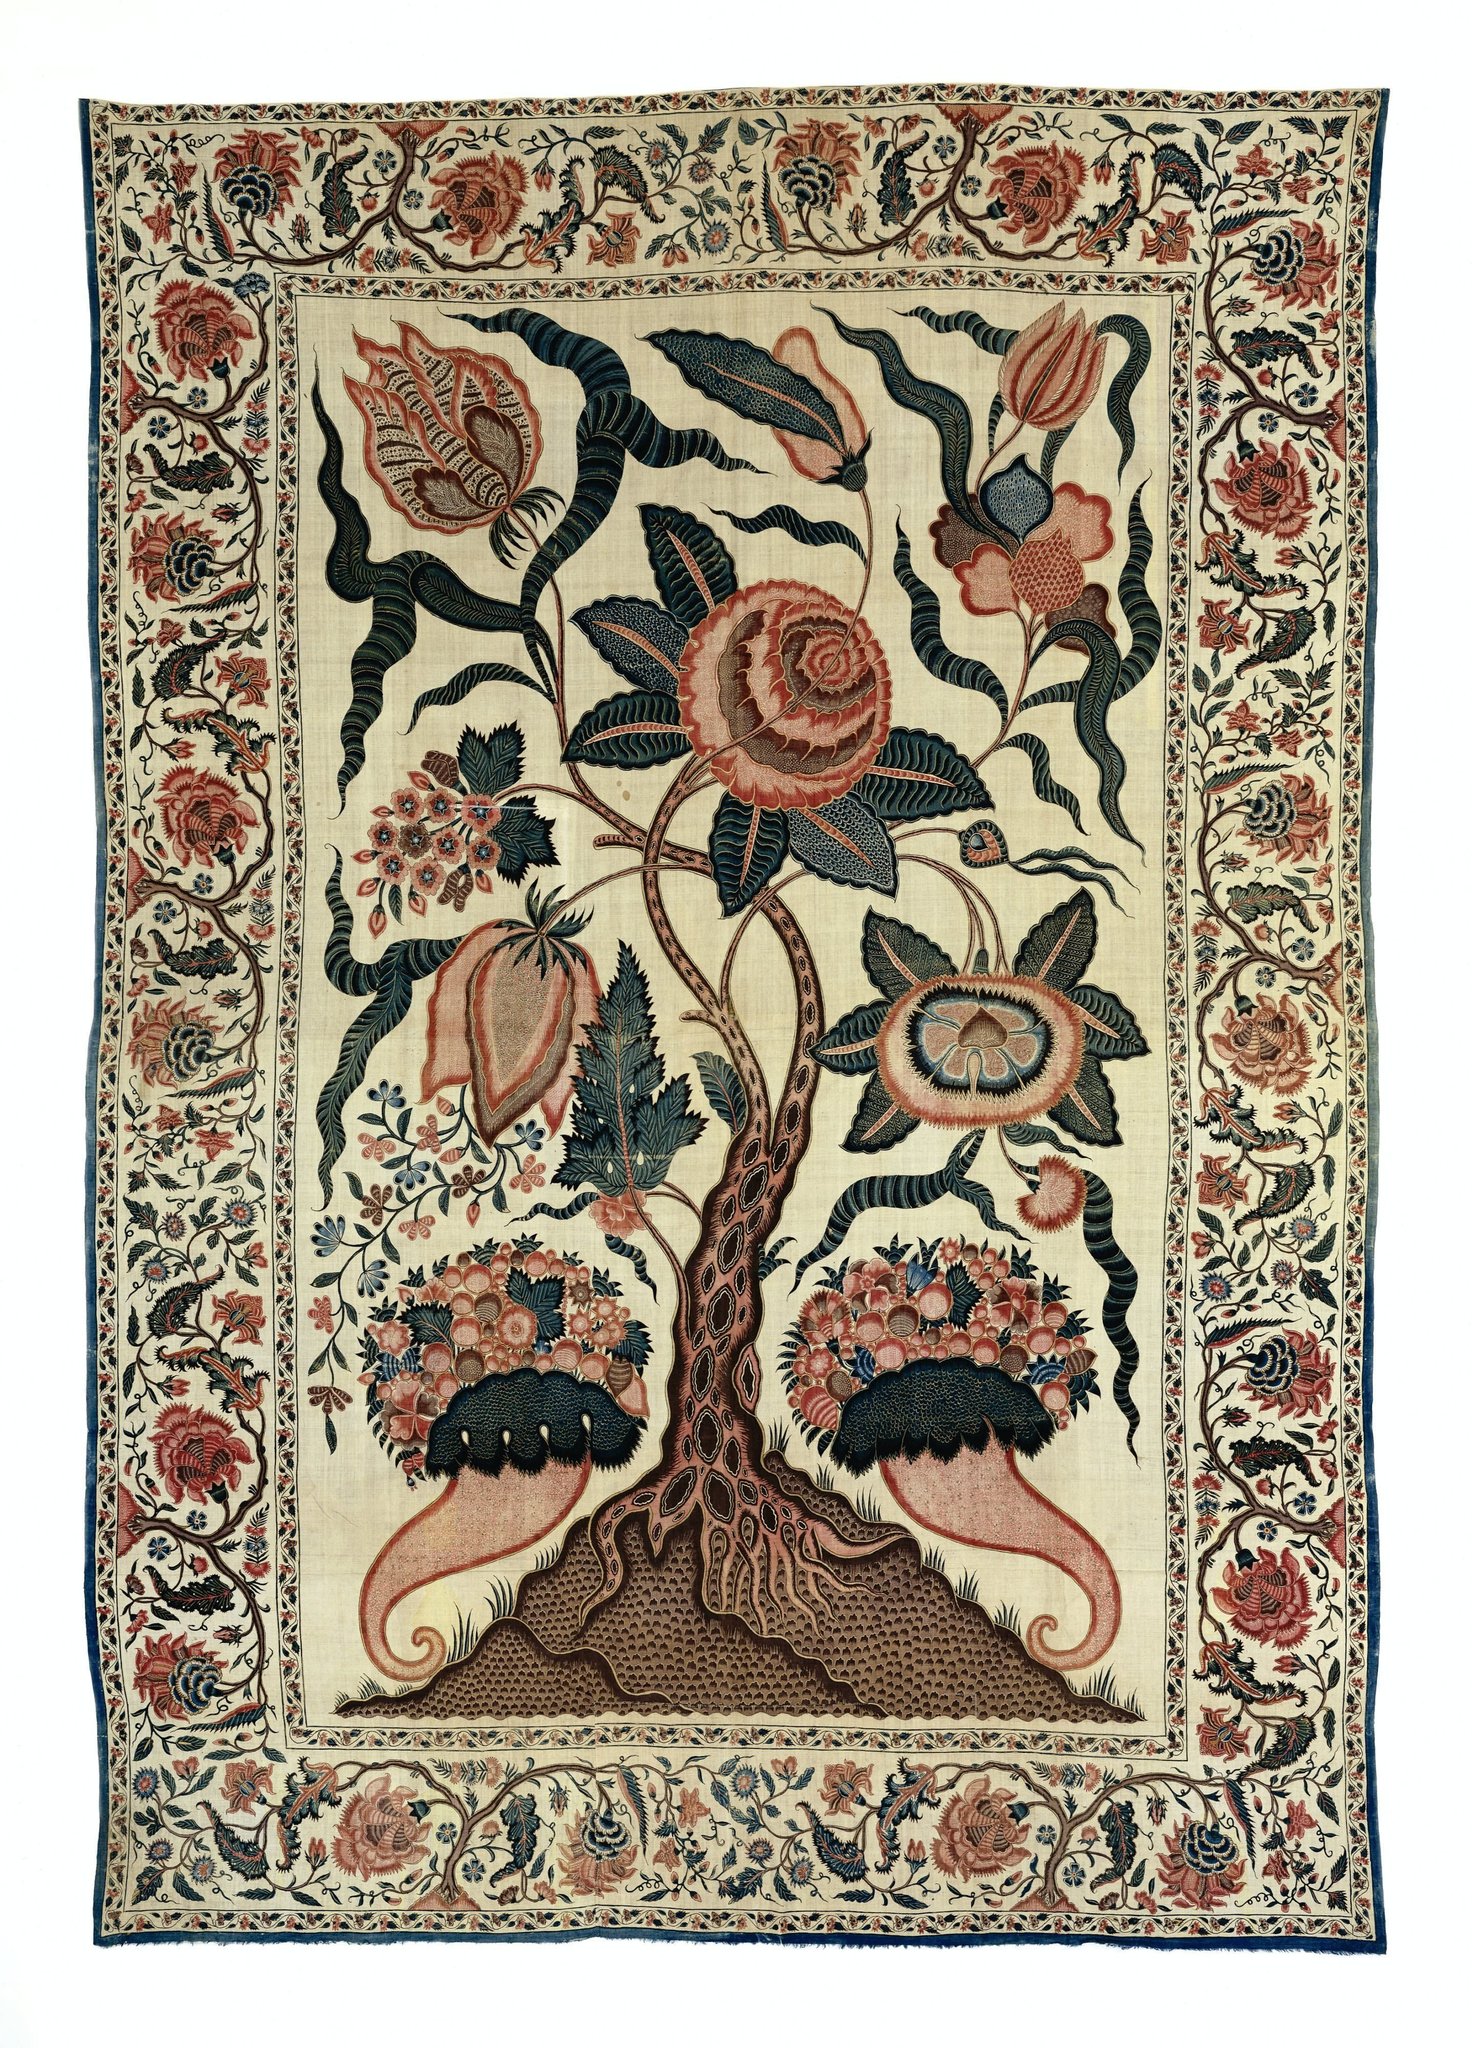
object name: palampore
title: Sprei of palempore van sits, versierd met een boom met grote bloemen en twee hoorns van overvloed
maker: Anonymous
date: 1750-1775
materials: cotton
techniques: painted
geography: coromandel coast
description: Sprei of palempore van sits, versierd met een boom met grote bloemen en twee hoorns van overvloed.